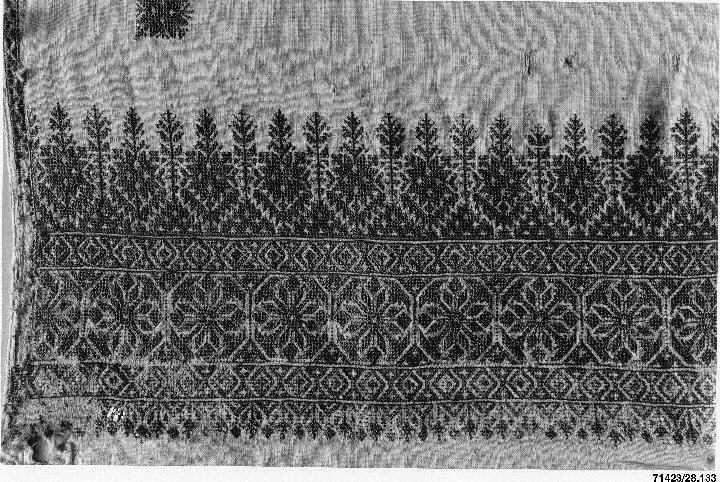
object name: towel end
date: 1701-1800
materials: linen, silk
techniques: embroidery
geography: morocco